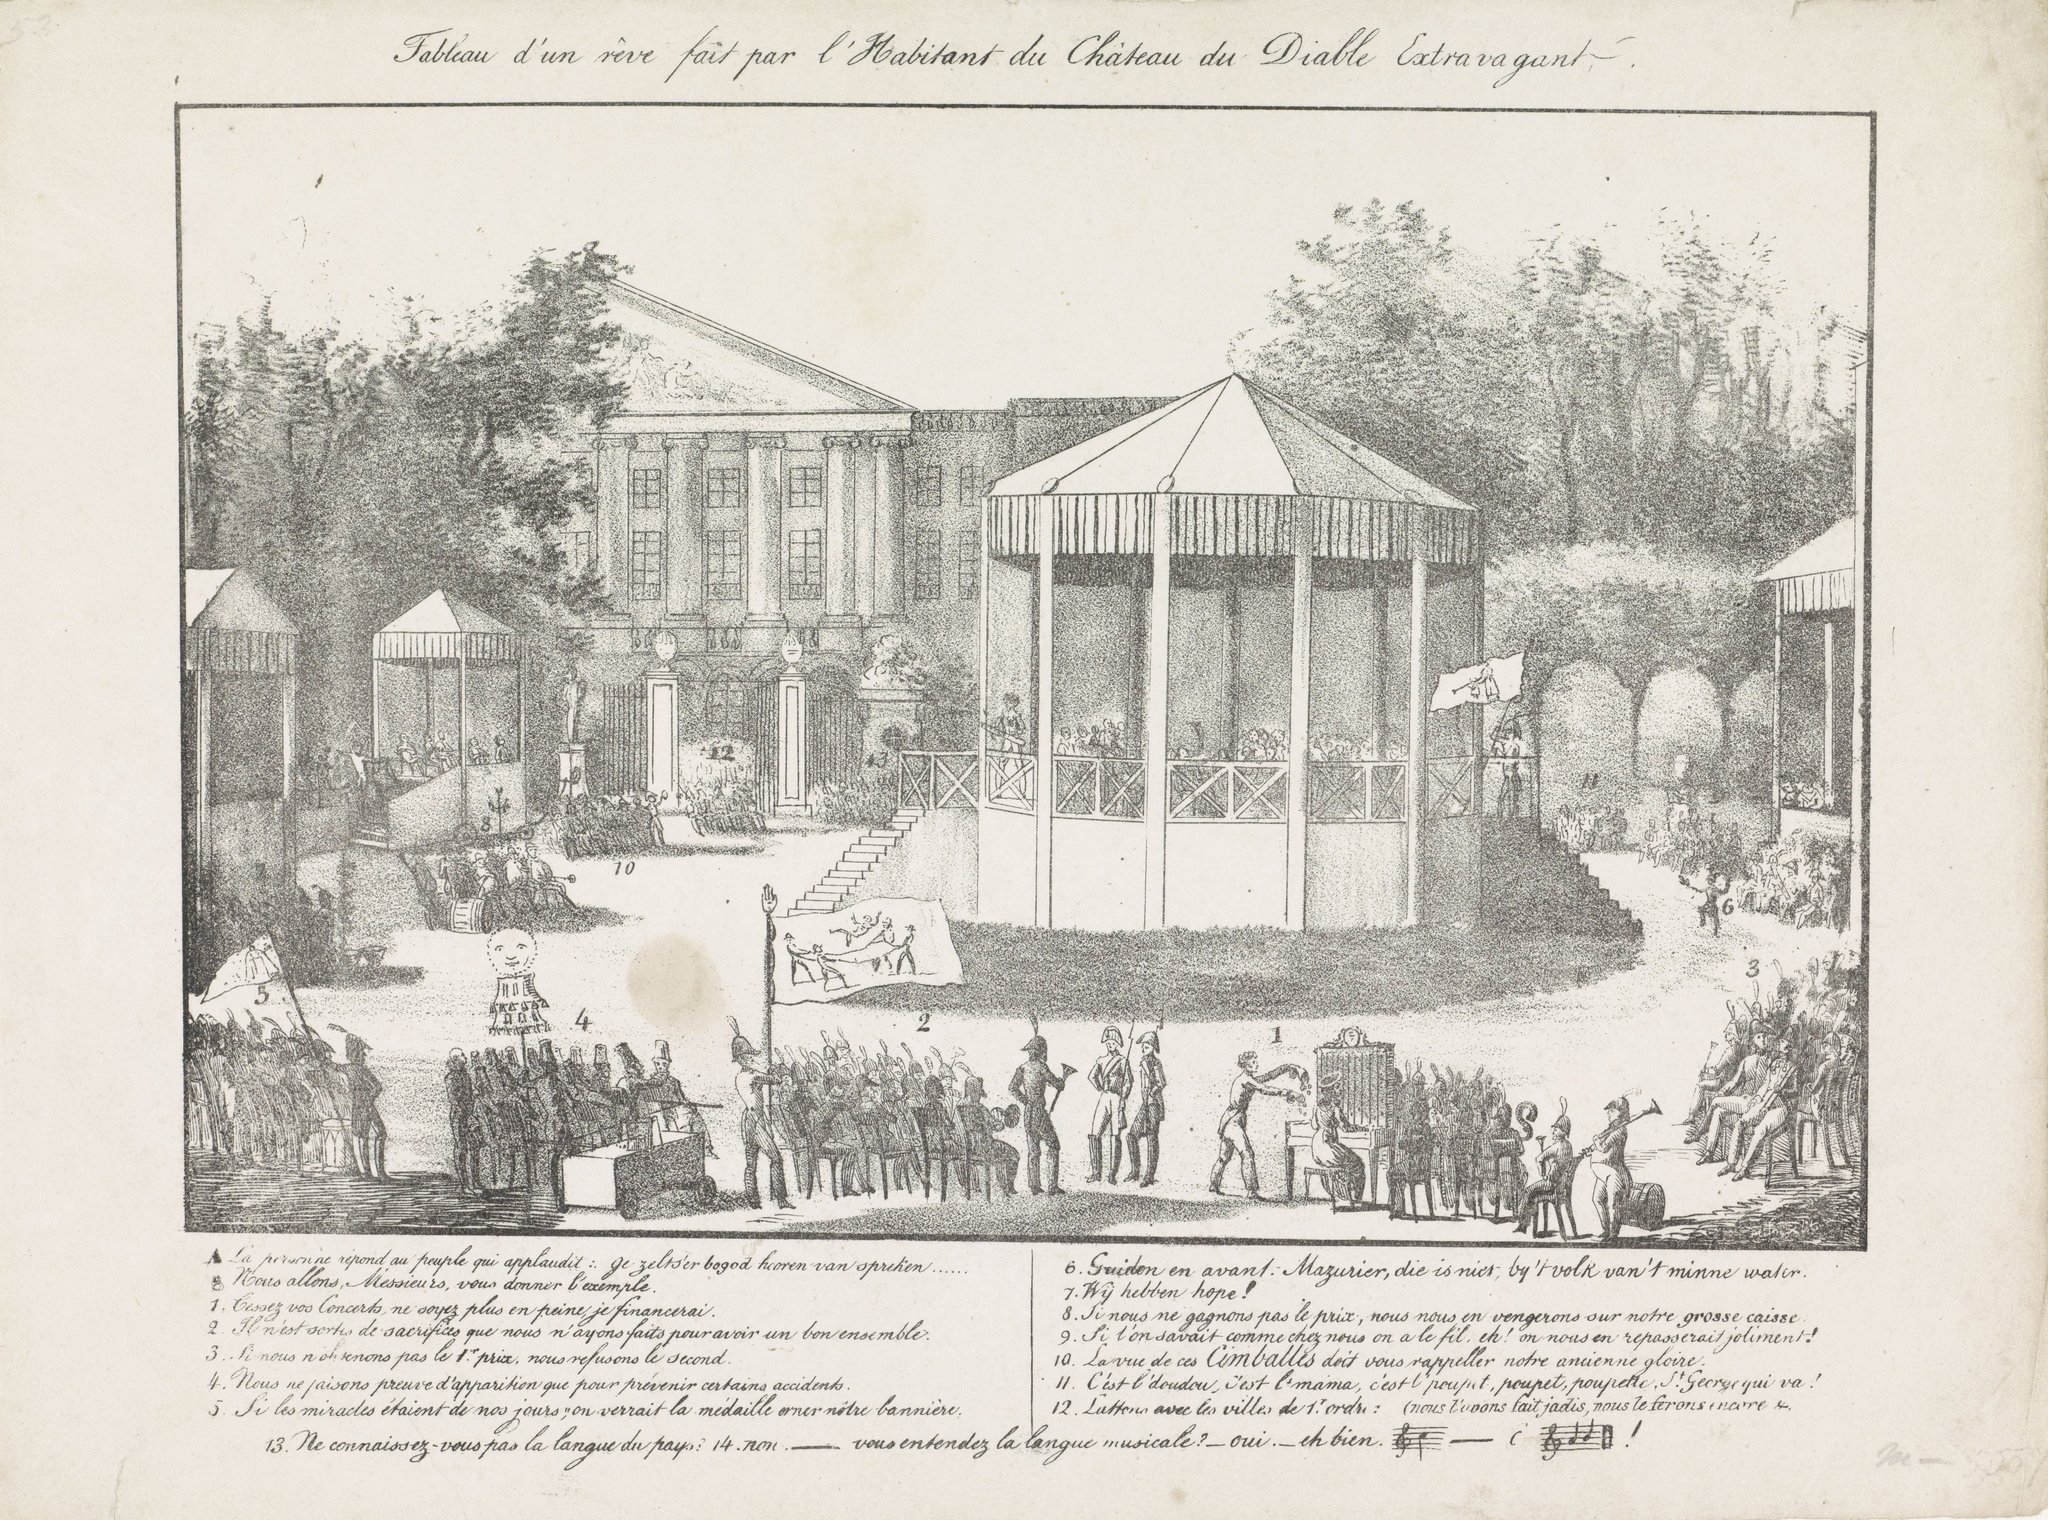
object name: print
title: Tableau d'un rêve fait par l'Habitant du Chateau du Diable Extravagant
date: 1830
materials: paper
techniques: lithograph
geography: brussels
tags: small group of musicians, chamber orchestra, jazz band, competition, art contest, brussels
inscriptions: collector's mark: Lugt 2228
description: Spotprent op het muziekconcours gehouden te Brussel in juli 1830. Gezicht op de muziektent in de Parc Royale waar het concours plaats vindt. Om de tent wachten de andere muziekkorpsen op hun beurt om te spelen. Links op de achtergrond het gebouw van de Staten-Generaal, daarvoor de tent met de jury. Met legenda A-B en 1-13.